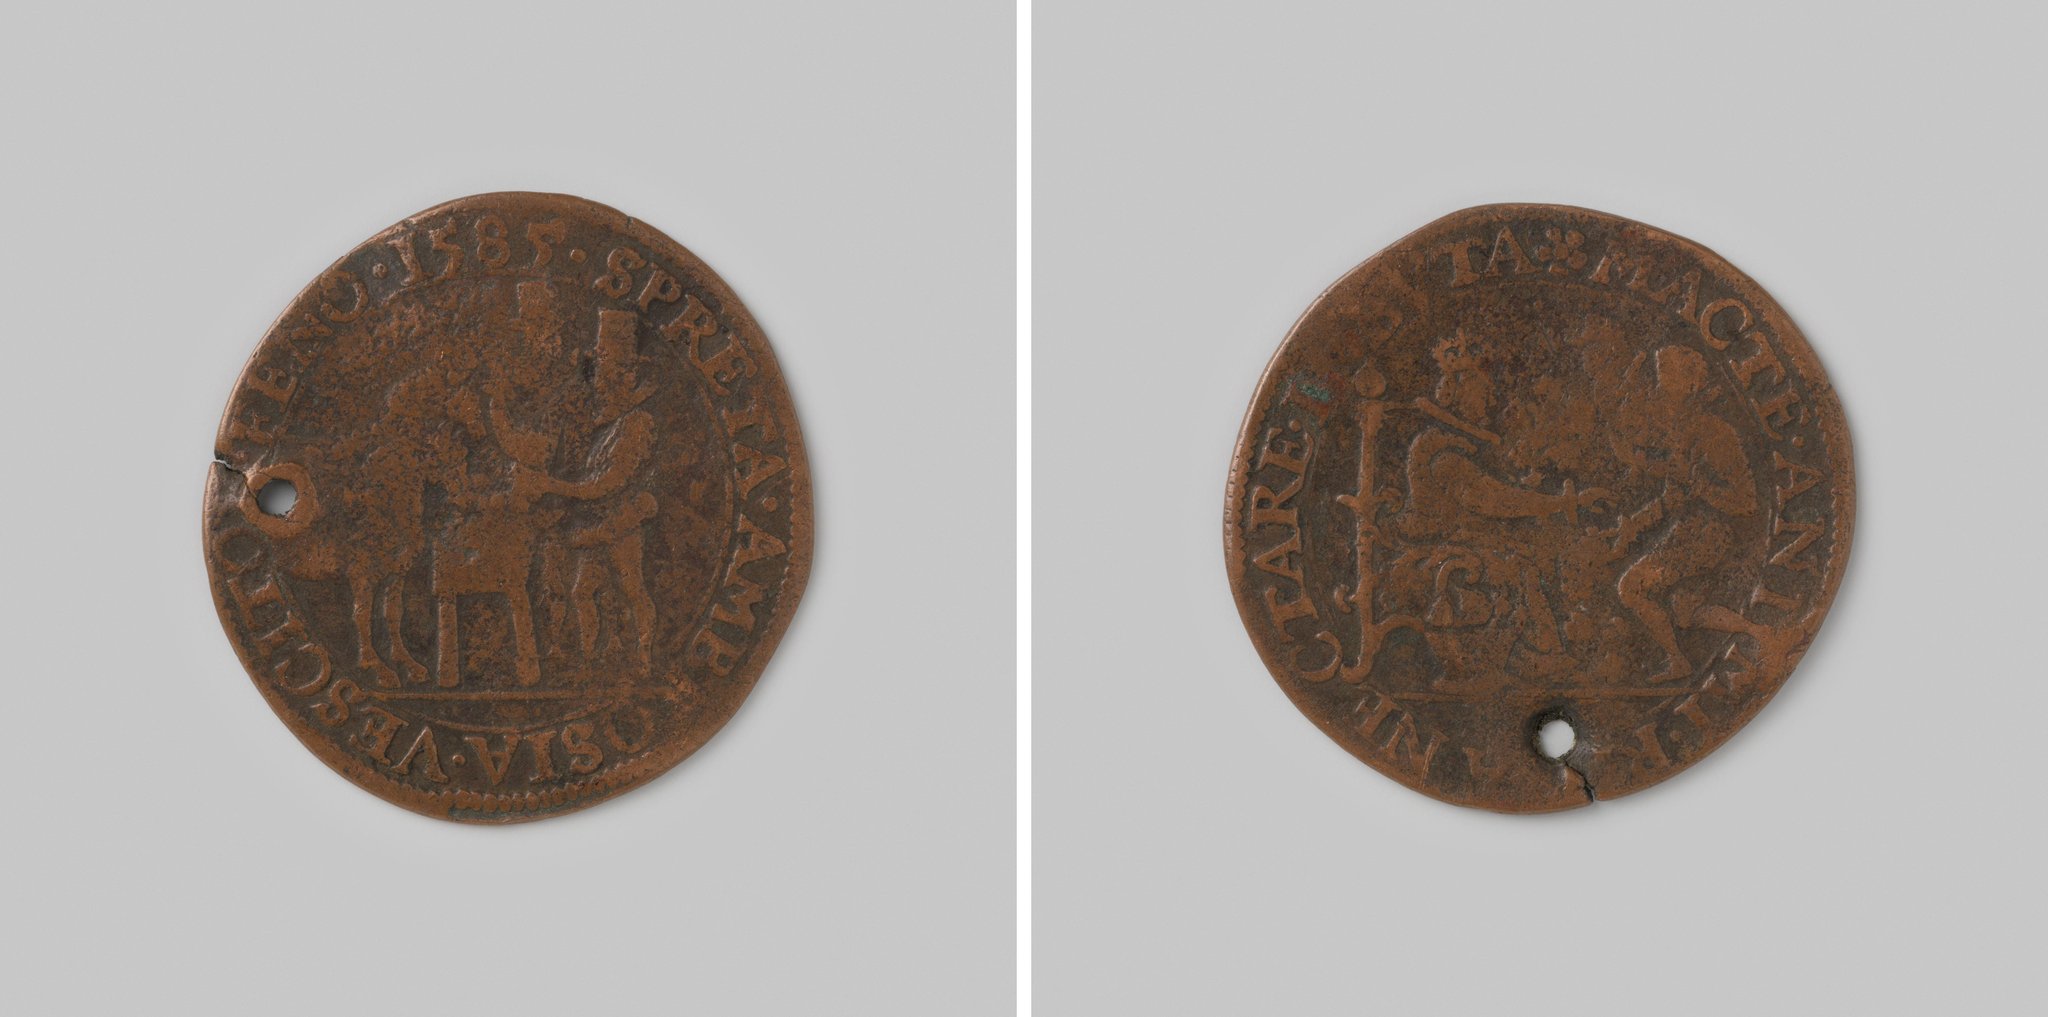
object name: jeton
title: Rekenpenning uit Dordrecht op de val van Antwerpen en hulp uit Engeland 1585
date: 1585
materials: copper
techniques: striking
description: Koperen penning met doorboring, op de voorzijde een paard en een ezel met twee Spanjaarden uit één trog etend, met omschrift, op de keerzijde de tronende Koningin Elisabeth van Engeland die rozen aan Nederlanders geeft, met omschrift.